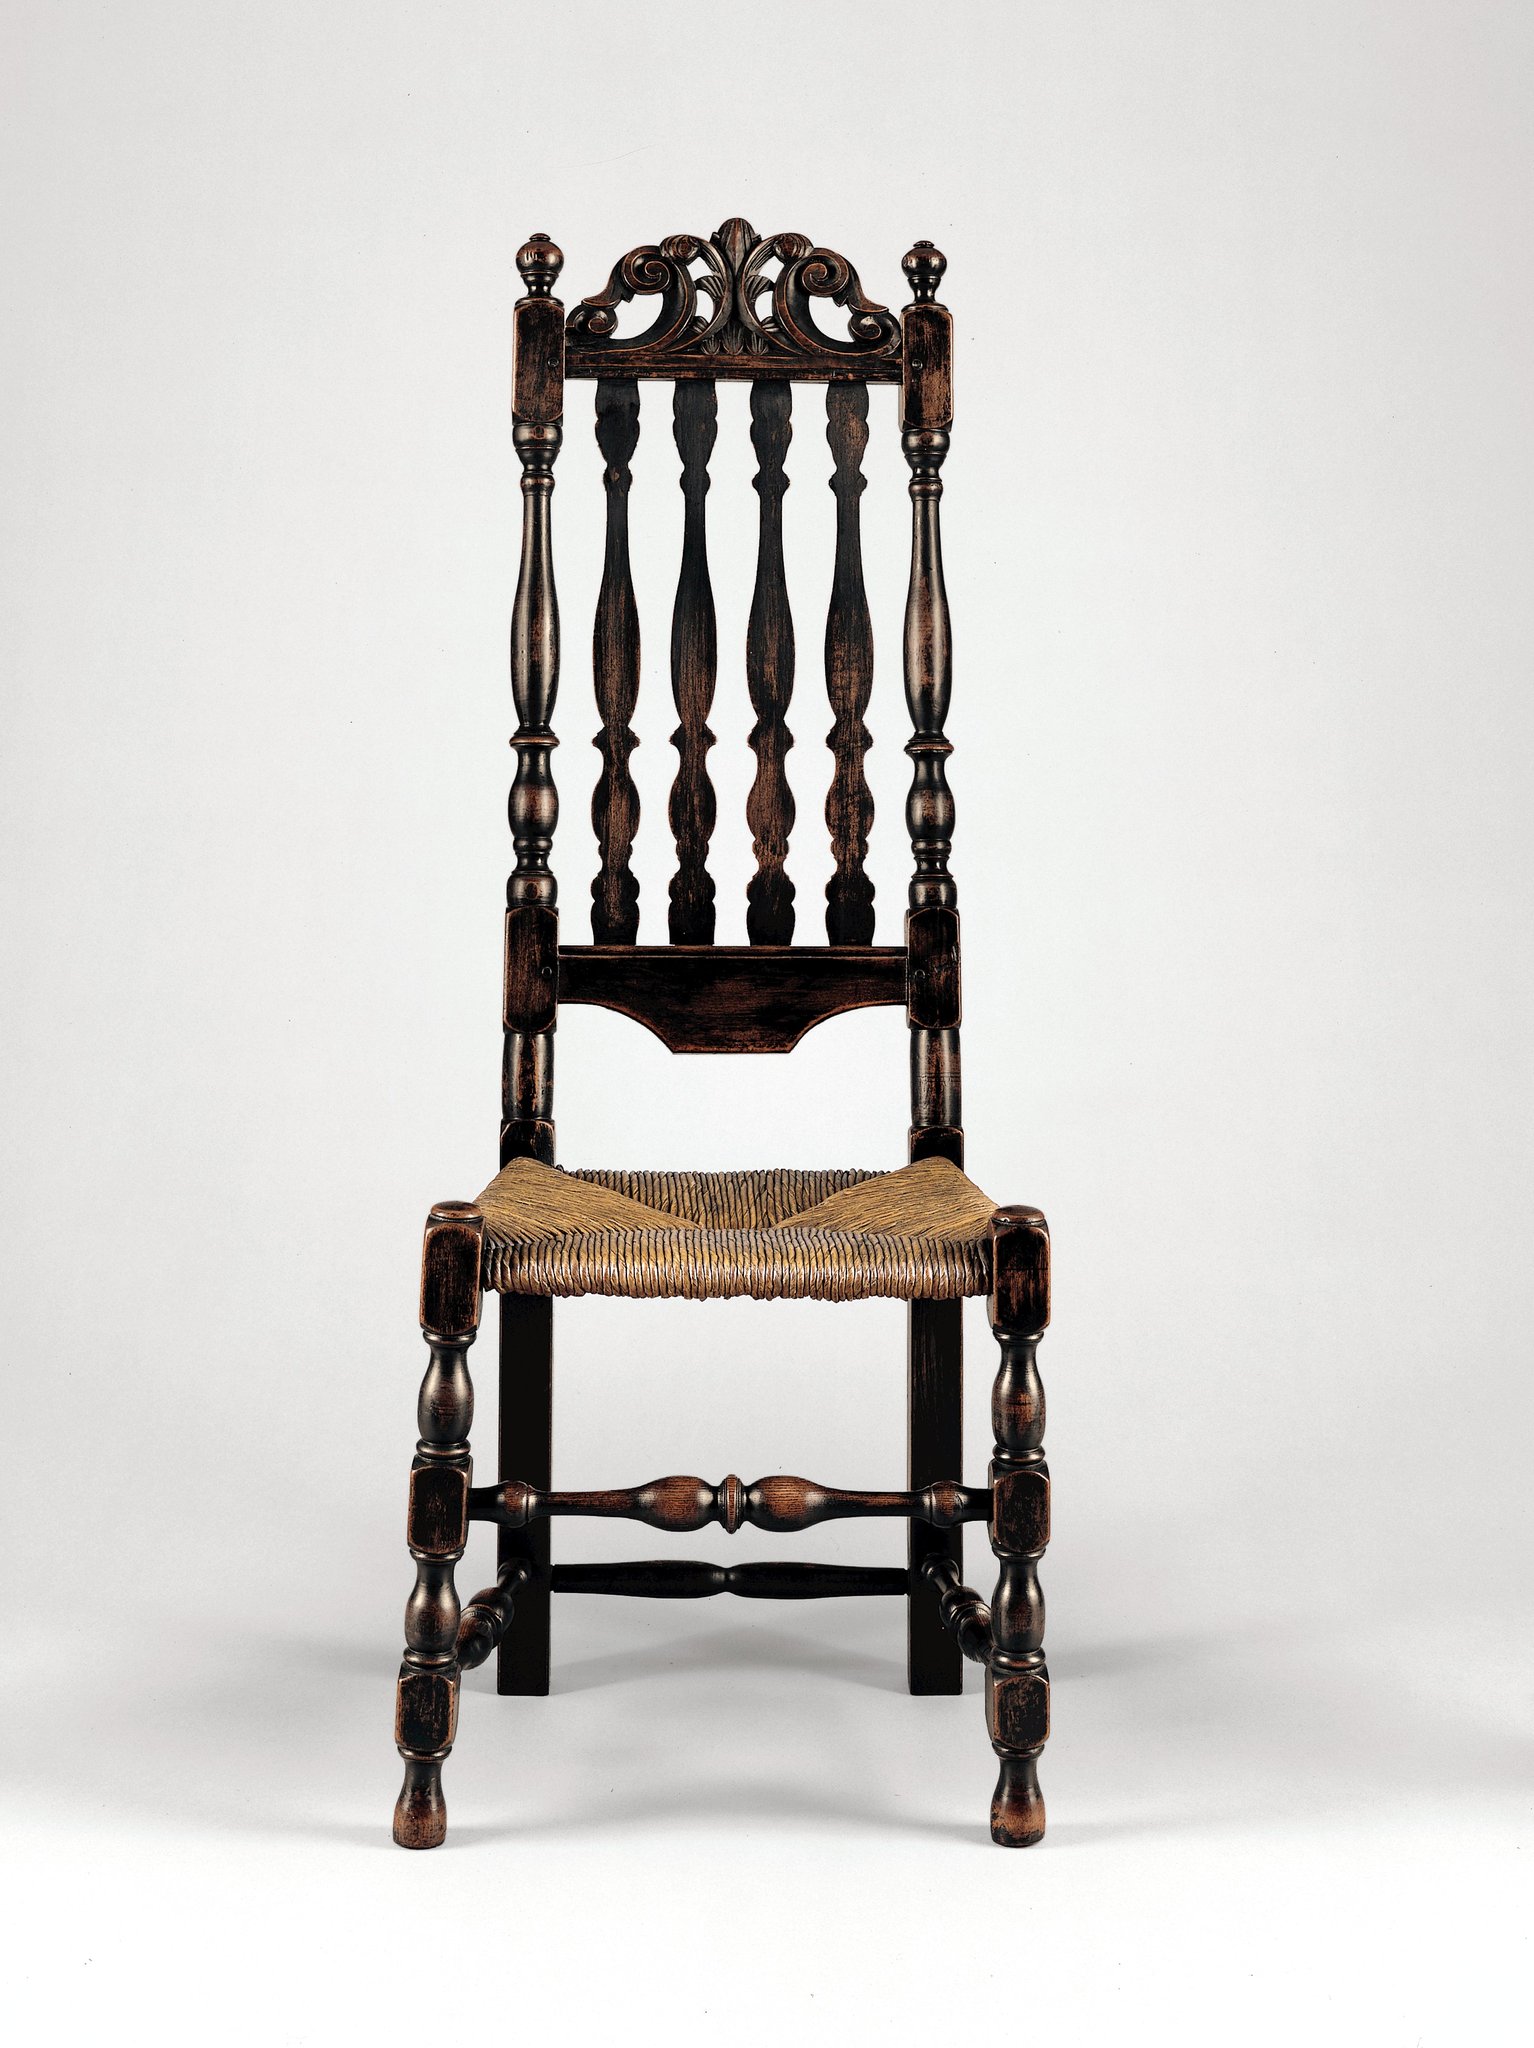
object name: side chair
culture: american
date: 1700-1730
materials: wood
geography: united states